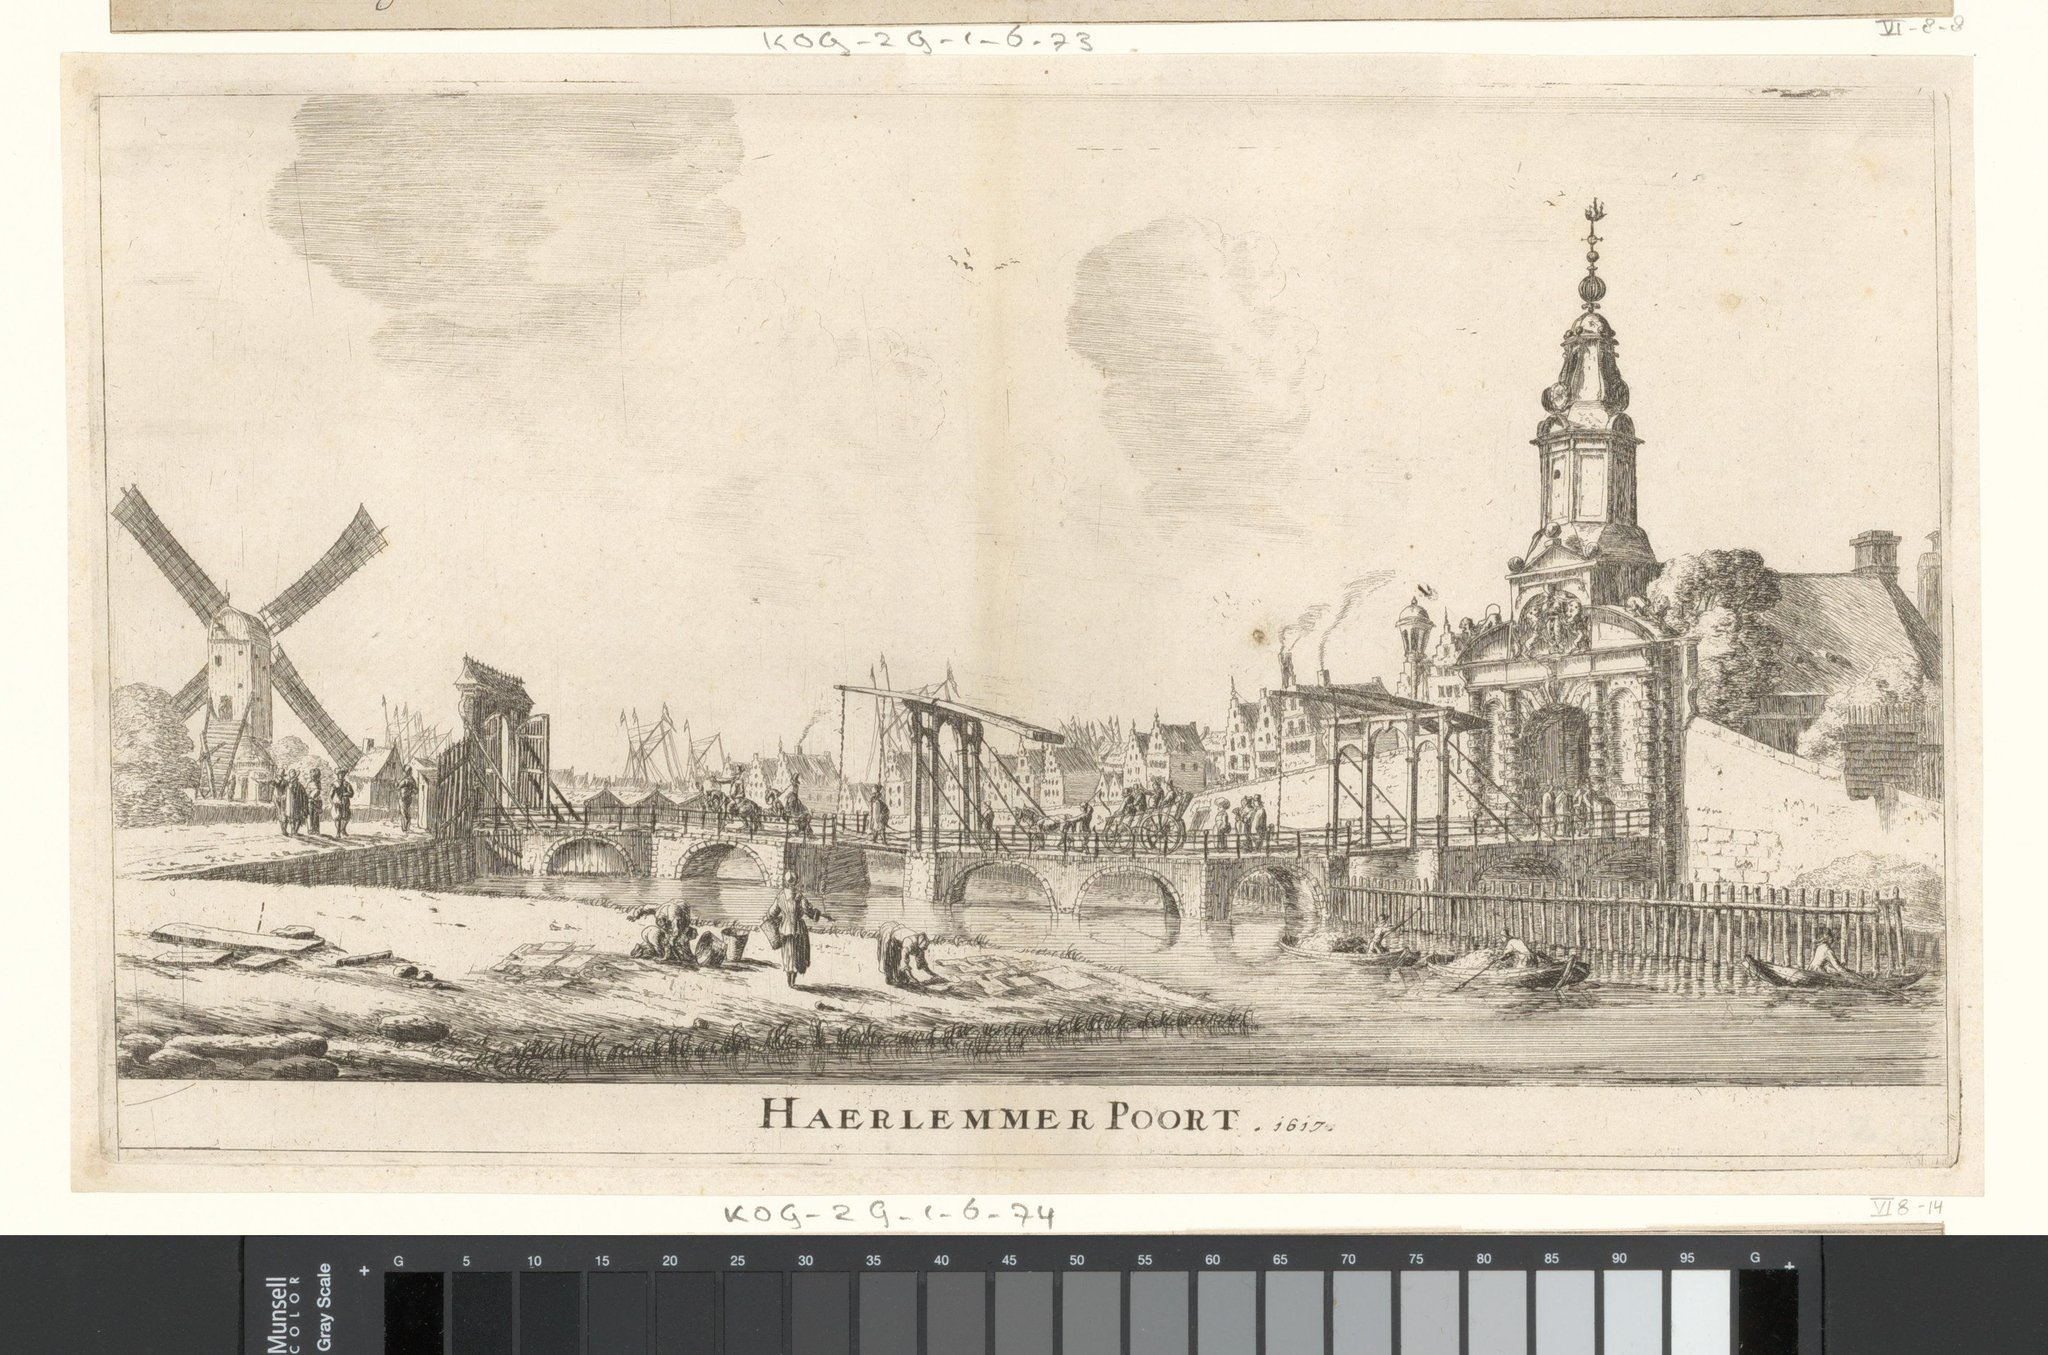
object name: print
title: Nieuwe en eygentlycke afbeeldinghe der stadts-poorten van Amsterdam in 't licht gebracht door R.N. Zeeman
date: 1654-1701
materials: paper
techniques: drypoint, engraving, etching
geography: amsterdam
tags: tower, clock tower ~ monumental adornment, windmill, city-gate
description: Onderdeel van een prentserie bestaande uit een titelprent en zeven prenten van Amsterdamse stadspoorten of alleen zeven (of zes) prenten van Amsterdamse stadspoorten. Van deze prentserie zijn drie uitgaven bekend, respectievelijk uitgegeven door Cornelis Danckerts (I), Dancker Danckerts en Justus Danckerts. Van de titelprent zijn drie staten bekend: één staat voor de letter waarop het droge naaldwerk nog goed zichtbaar is, één staat waarop Dancker Danckerts als uitgever vermeld staat; en één staat waarop Justus Danckerts als uitgever vermeld staat. De serie uitgegeven door Cornelis (I) Danckerts had mogelijk geen titelprent. Van elk van de overige prenten zijn redelijk wat exemplaren overgeleverd maar is telkens slechts één staat bekend. Op vier van deze prenten staat Cornelis Danckerts (I) vermeld als uitgever. Op twee prenten staat geen uitgever vermeld en op één prent staat Dancker Danckerts vermeld als uitgever. Mogelijk hebben zowel Dancker als Justus voor hun uitgave hun naam op de titelprent vermeld zonder de overige prenten bij te werken. Dat zou betekenen dat de prenten waarop Cornelis (I) staat vermeld als uitgever, ook later door zijn zoons Dancker en Justus kunnen zijn uitgegeven. En dat de prent waarop Danker vermeld staat als uitgever ook door Justus kan zijn uitgeven. Dat op de prent van de Derde Regulierspoort (RP-P-AO-27-15-2 en RP-P-1882-A-6003) wel - in een net andere stijl - de naam van Dancker Danckerts staat, zou verklaard kunnen worden doordat deze prent iets later, na het overlijden van Cornelis (I) in 1656, aan de serie is toegevoegd. De serie bevat namelijk ook een prent van de Tweede Regulierspoort (RP-P-AO-27-4-2 en RP-P-OB-20.579). Deze houten poort werd in 1654 afgebroken en vervangen door de stenen Derde Regulierspoort die in 1655 voltooid zou zijn.